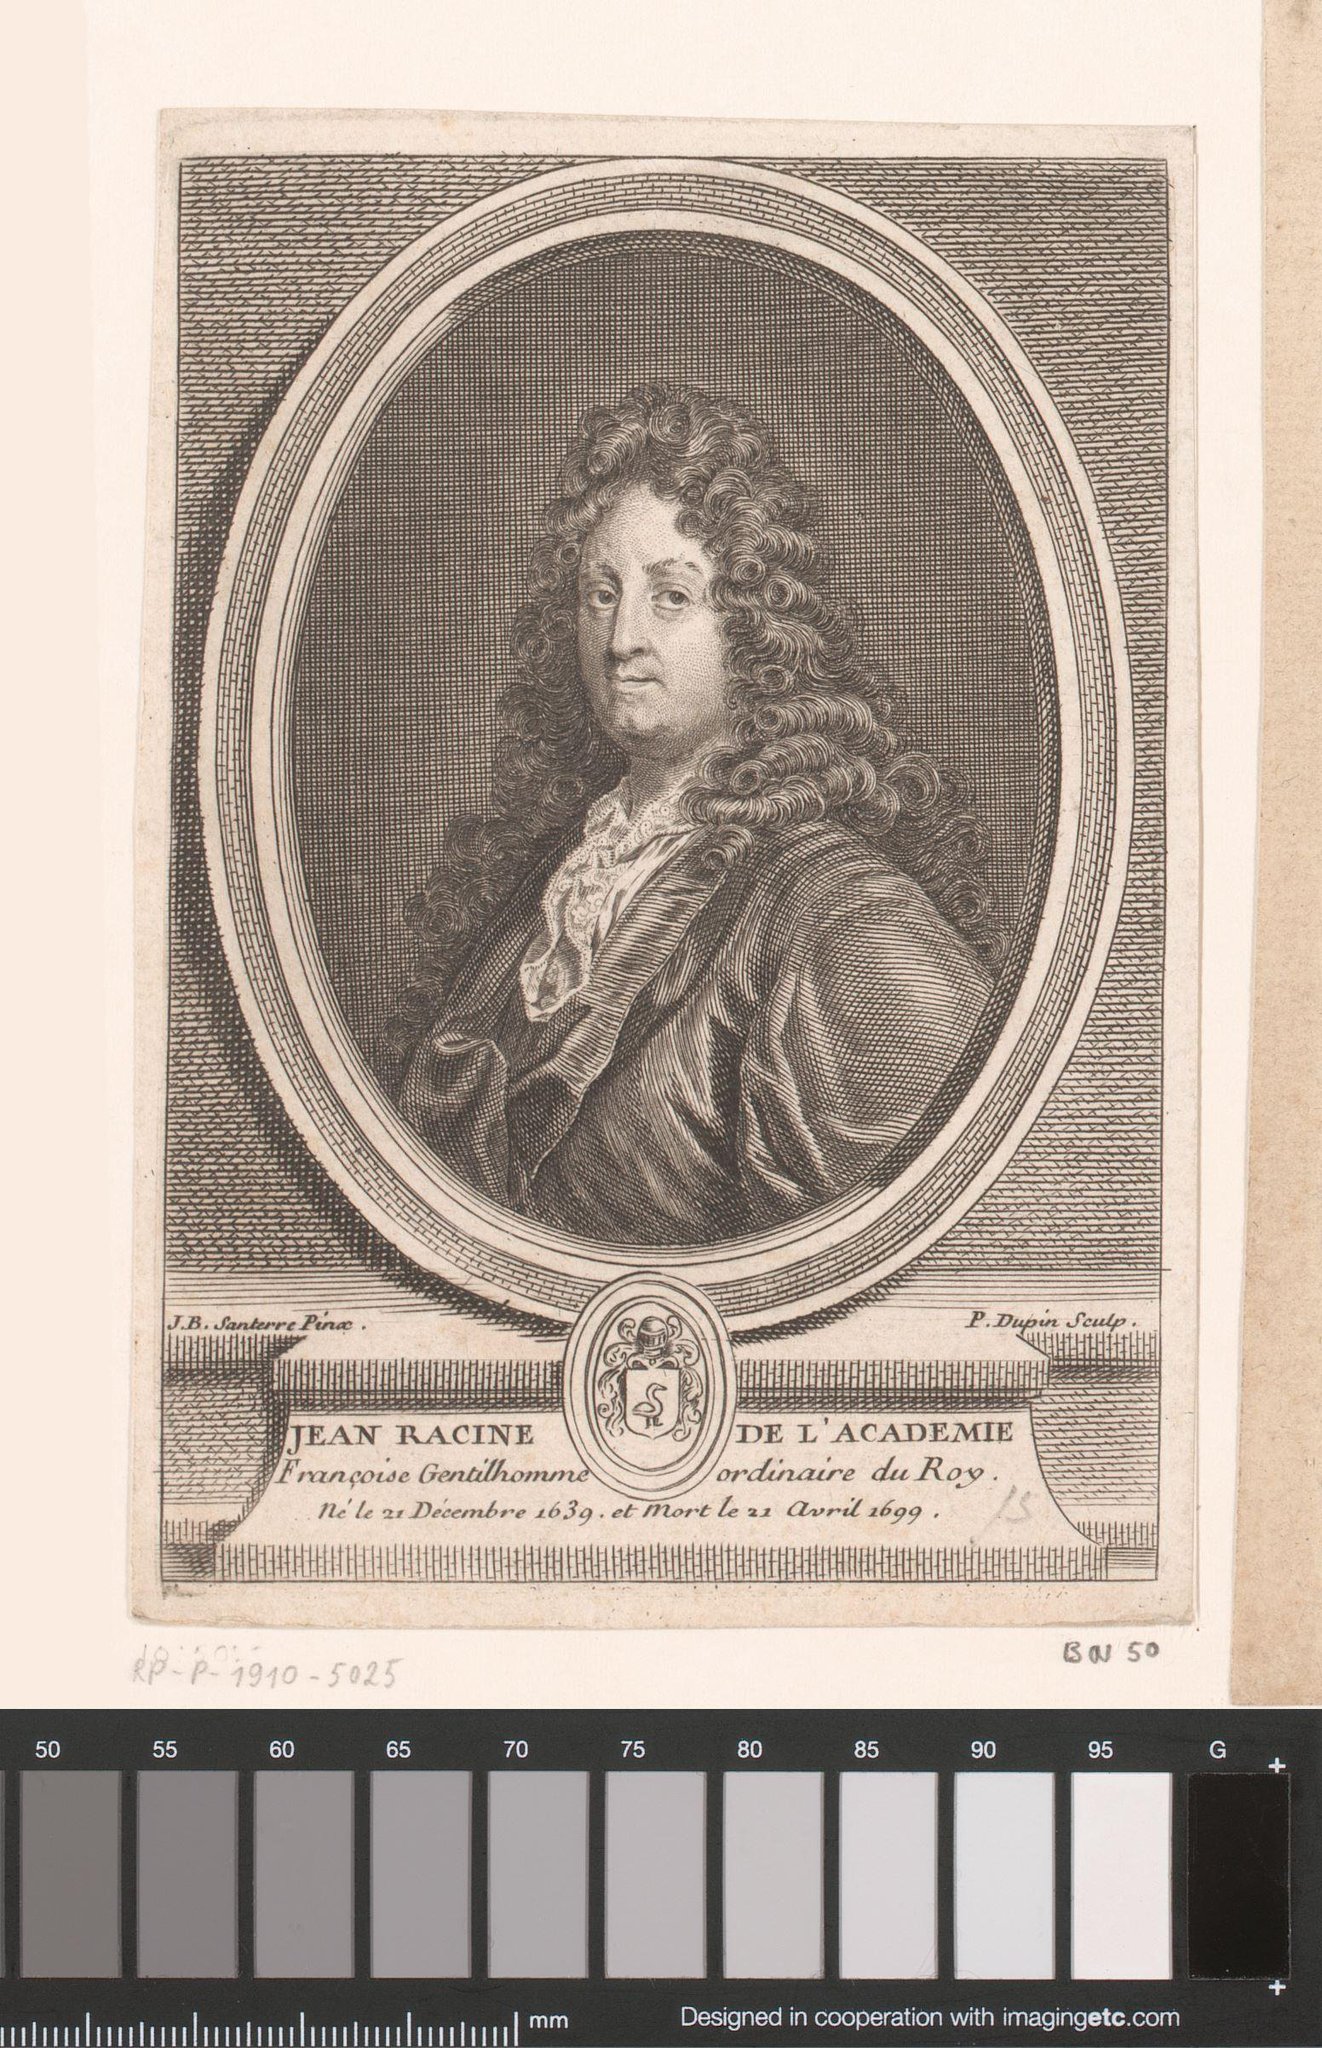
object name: print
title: Jean Racine de l'Academie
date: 1700-1751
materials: paper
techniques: engraving, etching, letterpress printing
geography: france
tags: france, paris, jean racine, theatre, theatrical performance, ornament ~ medallion, portrait, self-portrait of artist, armorial bearing, heraldry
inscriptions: collector's mark: Lugt 2228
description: Mogelijk diende deze prent als boekillustratie voor een onbekend boek.